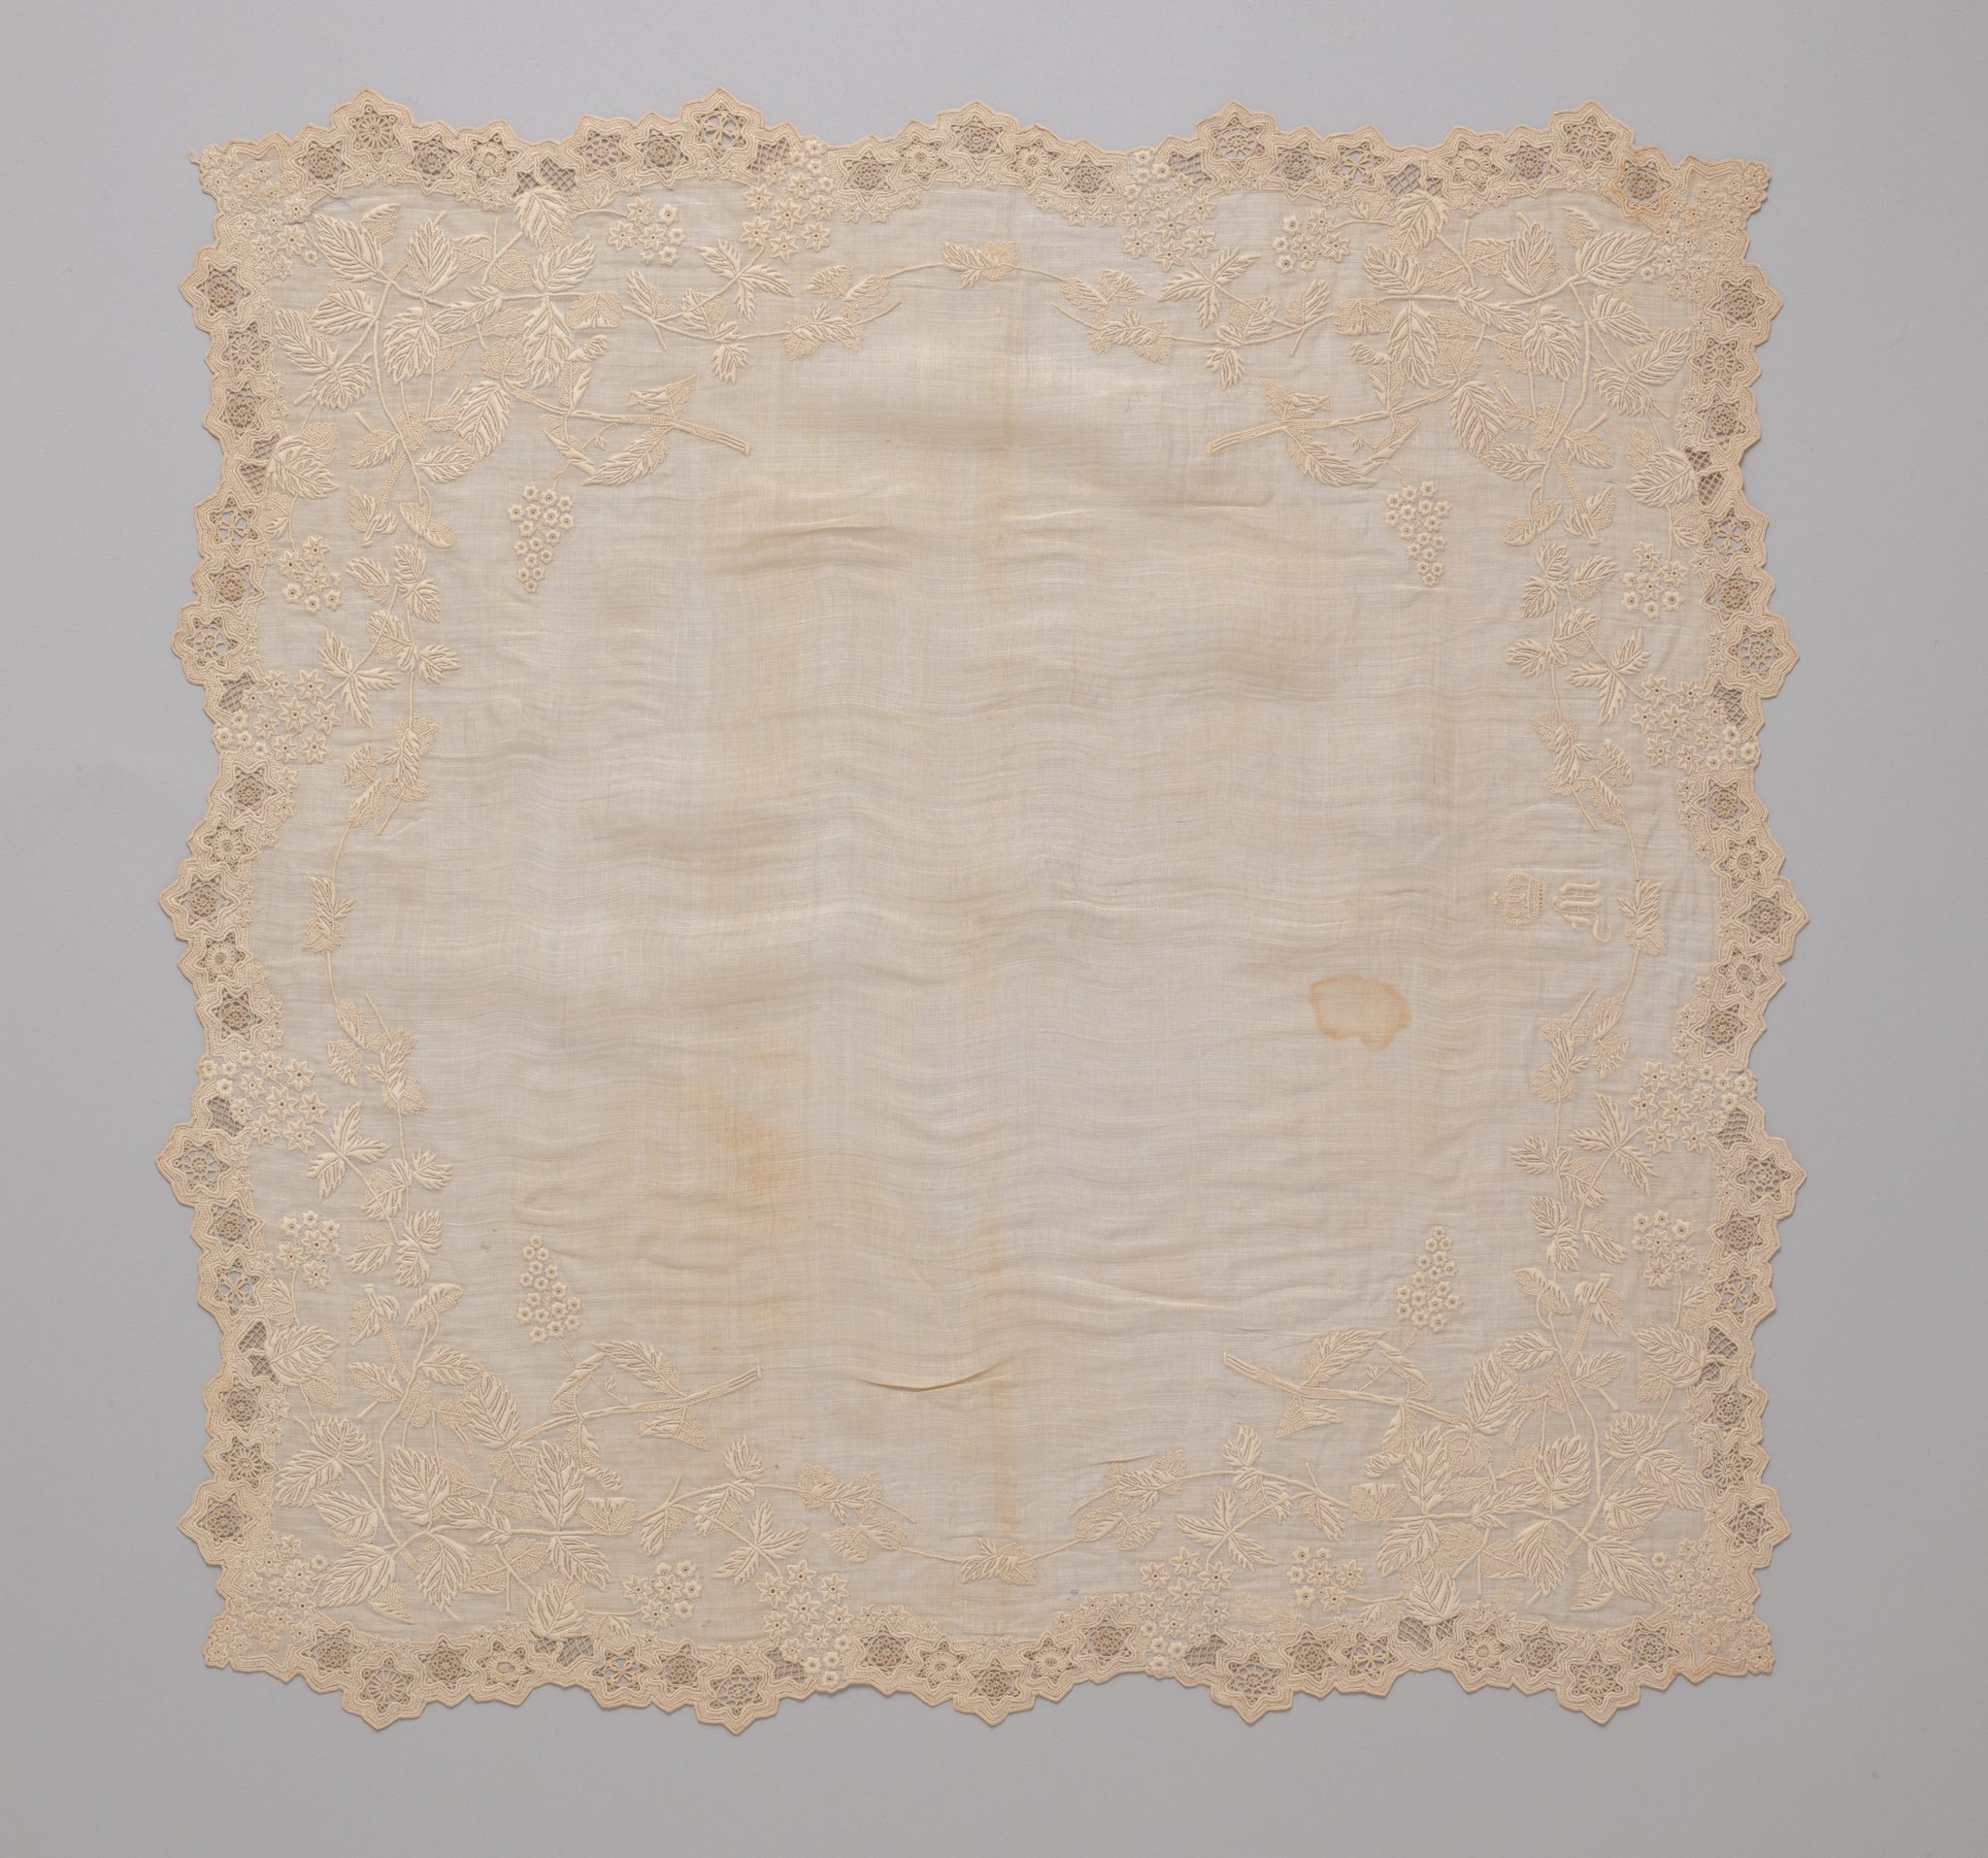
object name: handkerchief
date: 1840-1880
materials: linen, silk